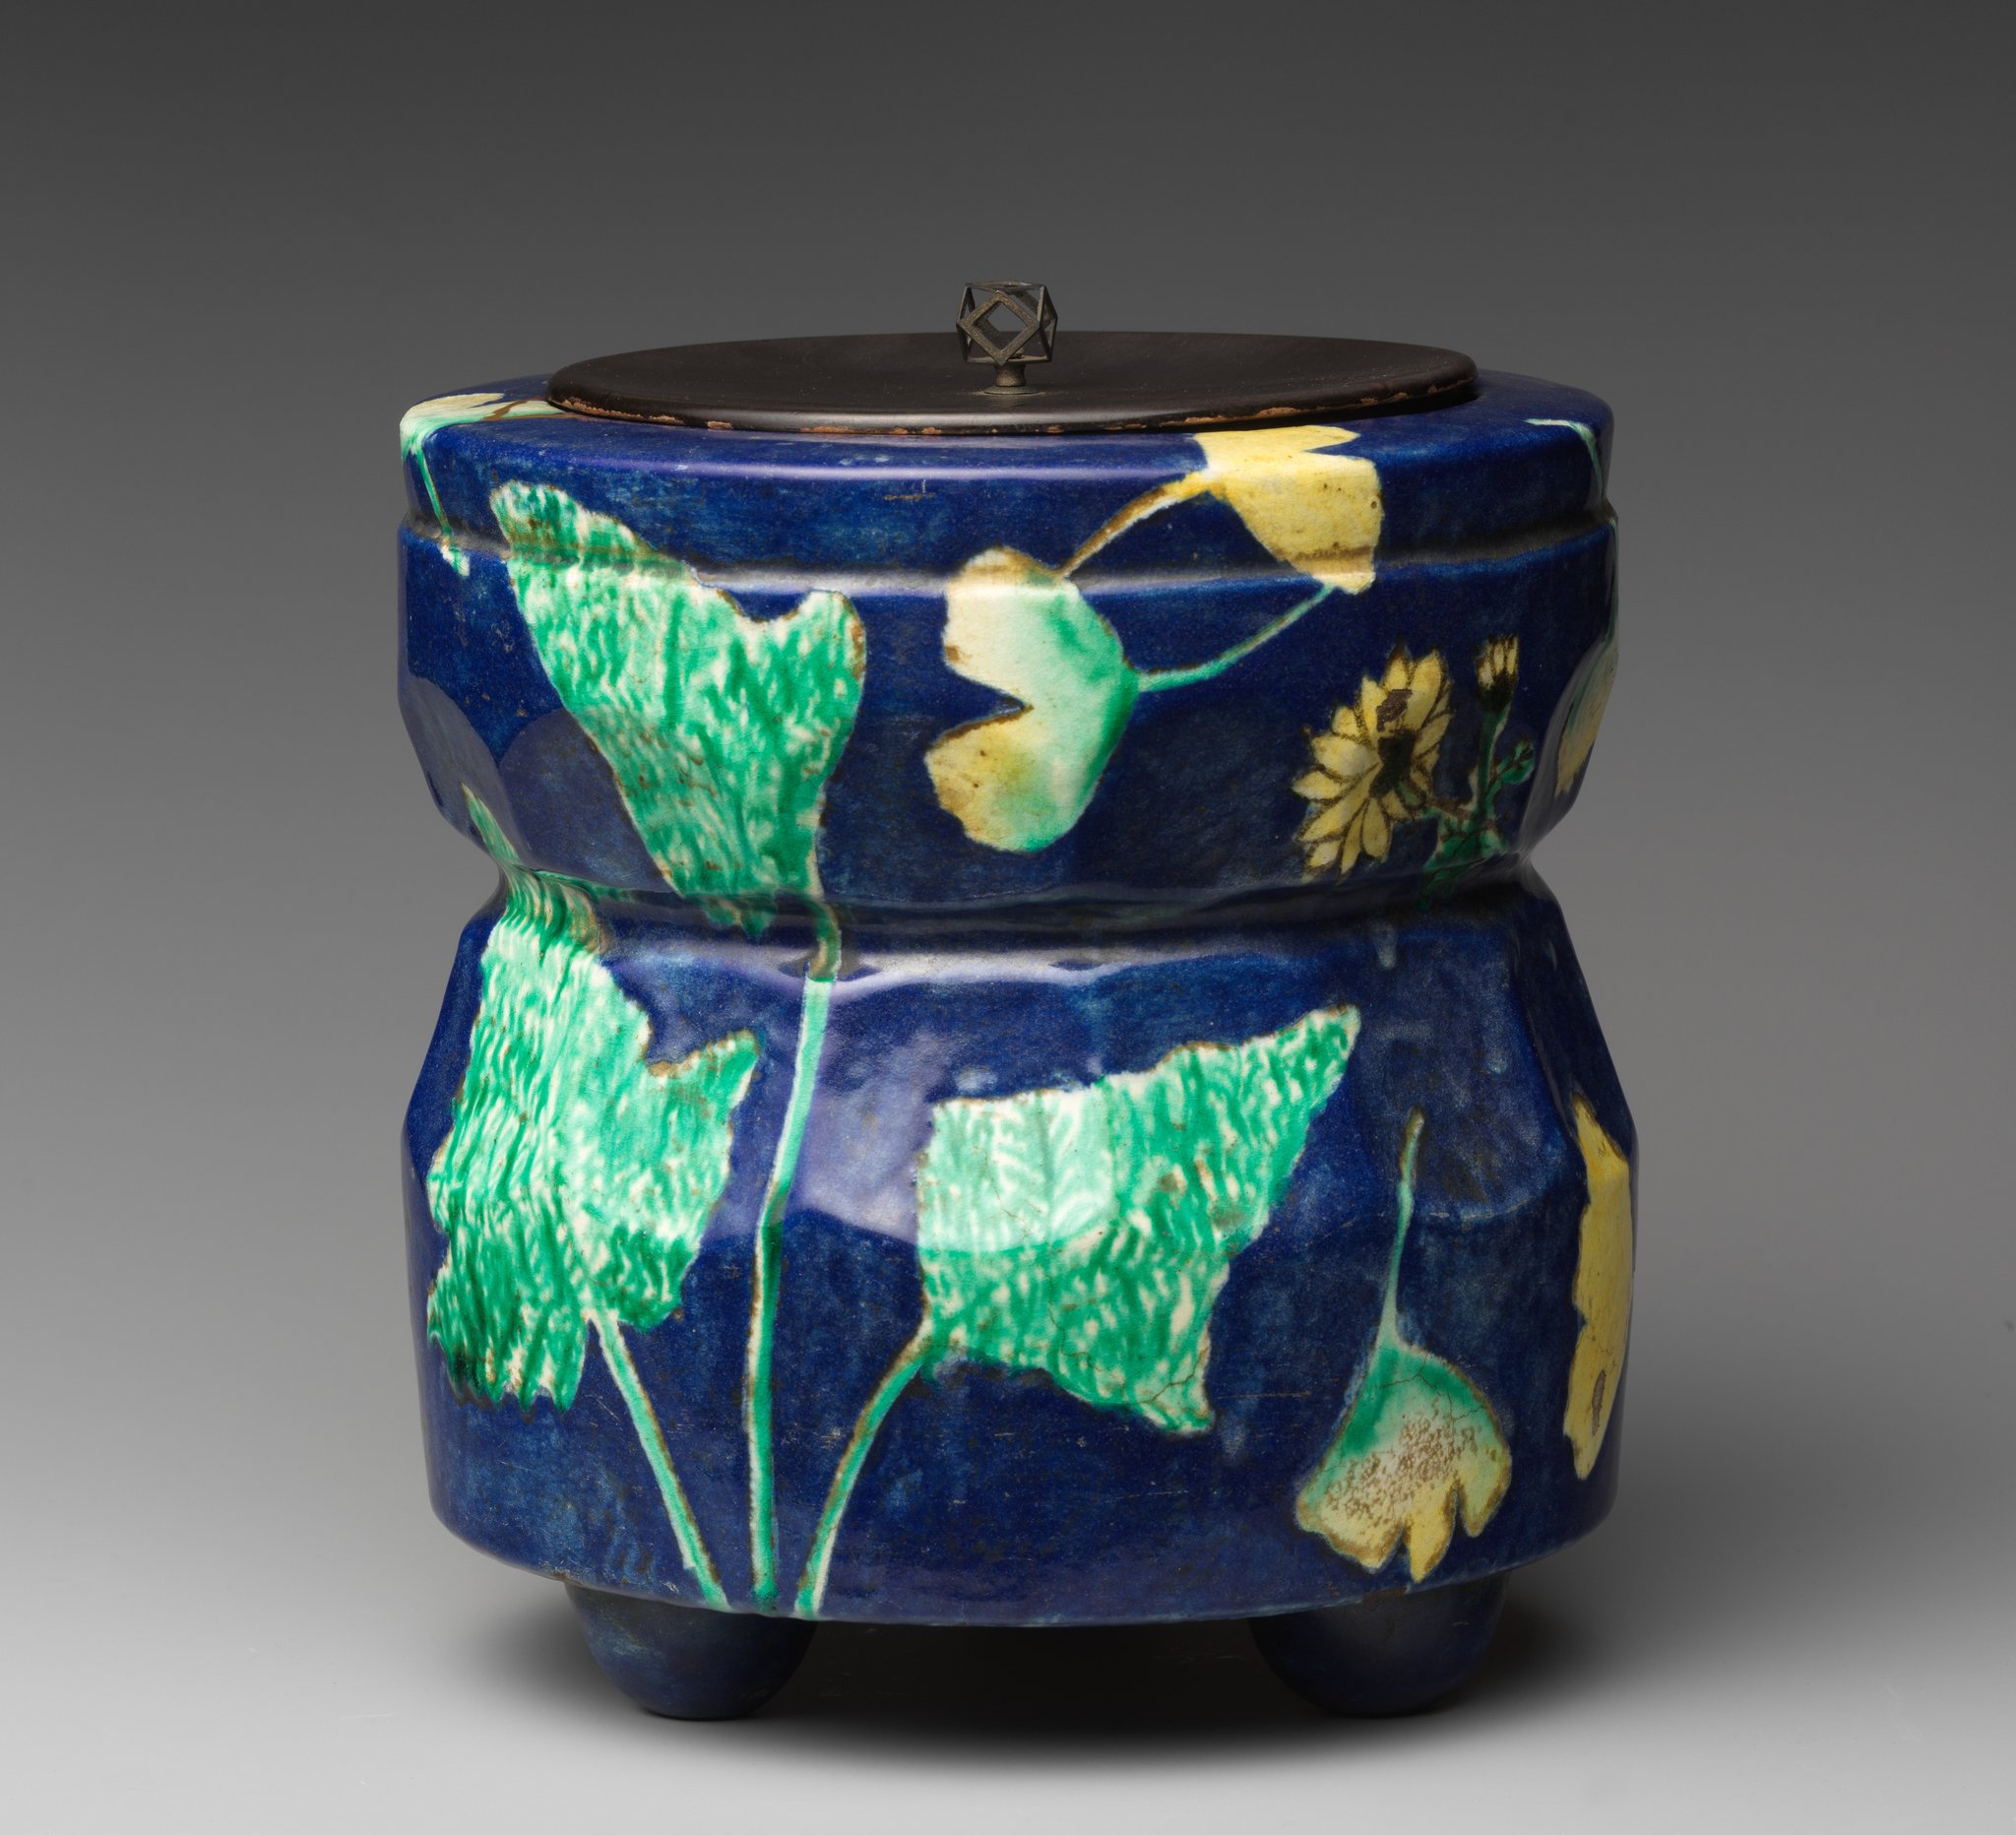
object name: water jar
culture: japanese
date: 1801-1833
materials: glaze, pottery